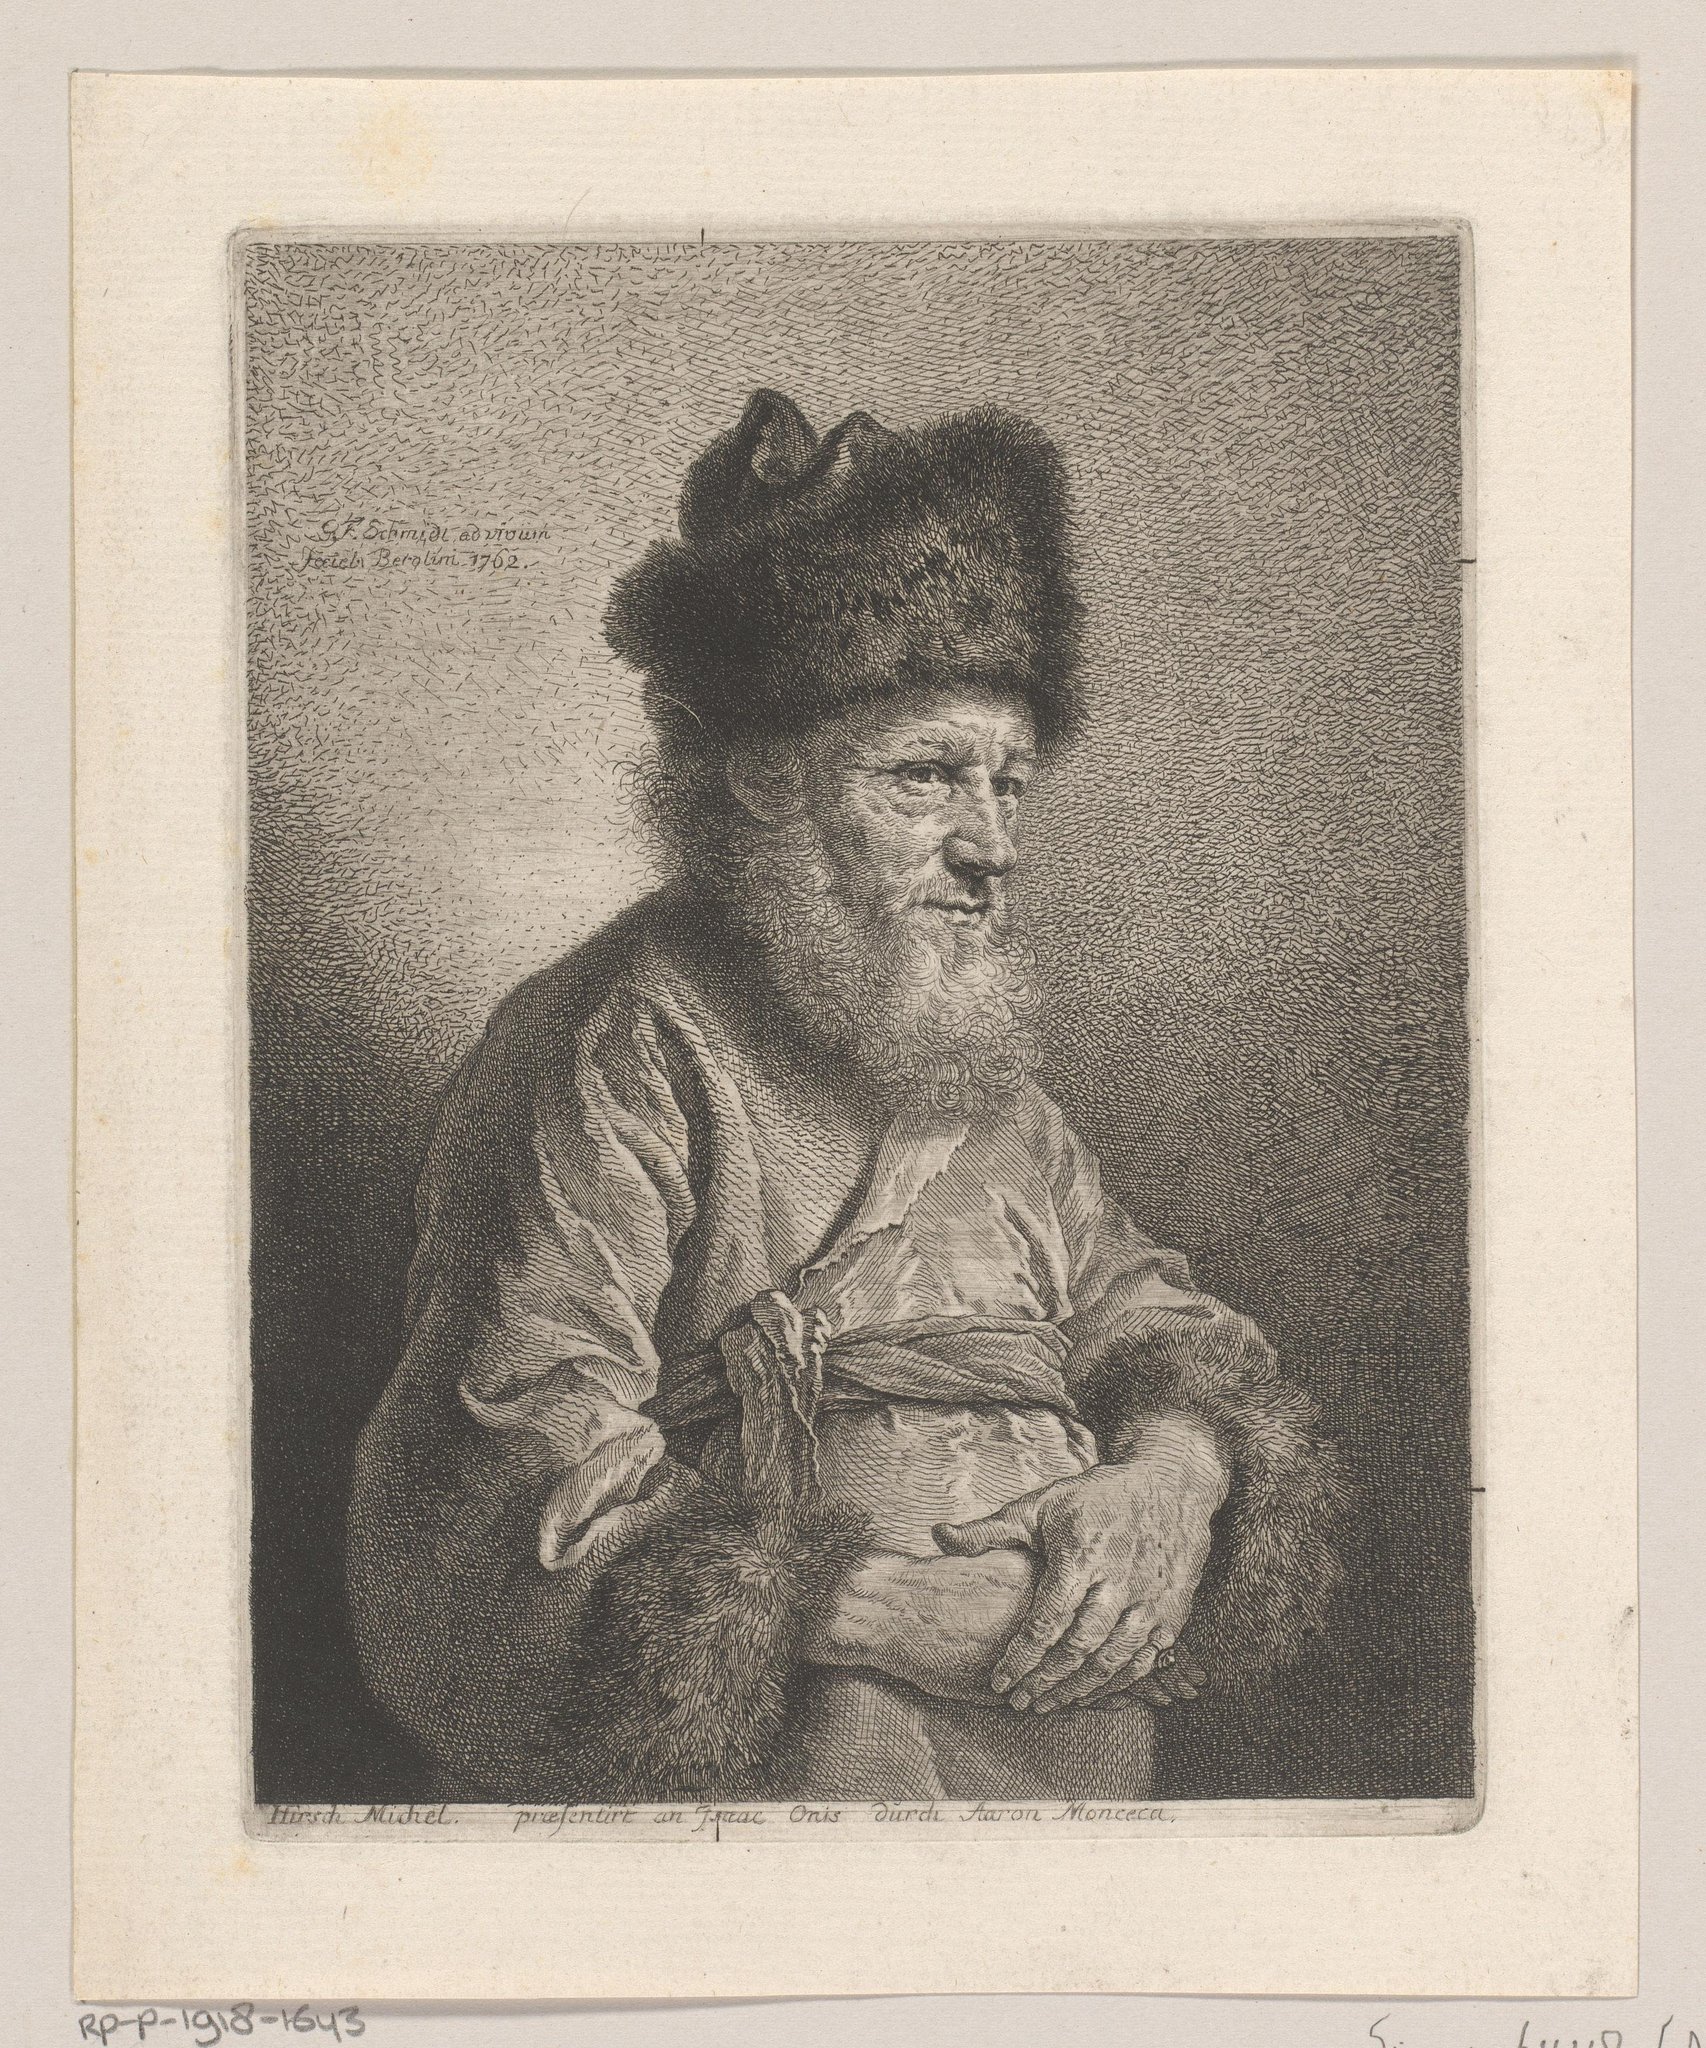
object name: print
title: Portret van Jechiel Michel Hirsch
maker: georg friedrich schmidt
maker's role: draughtsman, print maker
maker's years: 1712-1775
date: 1762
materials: paper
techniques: etching, intaglio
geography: berlin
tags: head-gear: cap (+ men's clothes), historical persons, rabbi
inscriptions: collector's mark: Lugt 2233